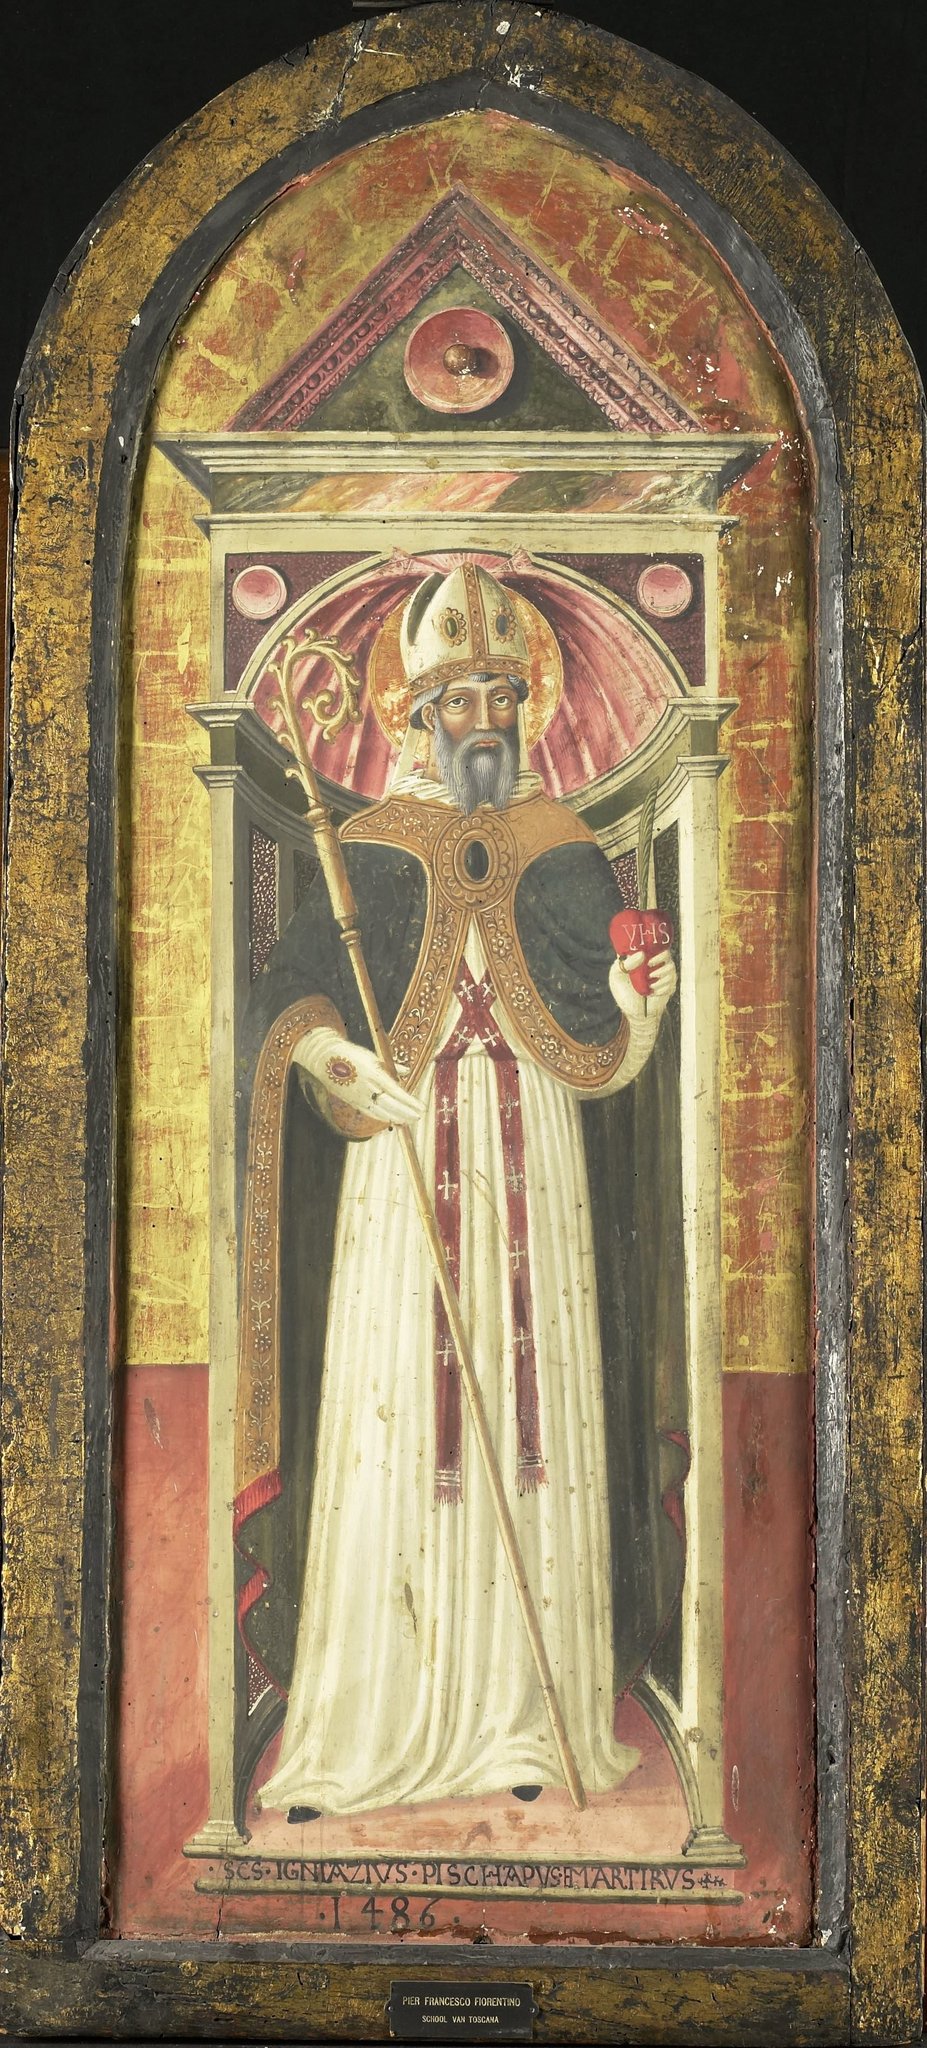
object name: fragment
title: Saint Ignatius of Antioch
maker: Anonymous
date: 1460-1499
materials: oil, panel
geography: tuscany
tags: the bishop of antioch, ignatius (theophoros); possible attributes: heart with ihs monogram, (two) lion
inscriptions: : ‘Scs Igniazius. Pischapus. Martirus. 1486’, inscription: ‘Scs Igniazius. Pischapus. Martirus. 1486’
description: De heilige Ignatius van Antiochie. De heilige bisschop staande, ten voeten uit, bisschopsstaf in de rechterhand, een hart met palmtak in de linkerhand. Behoorde samen met SK-A-3397 tot een groter altaarstuk of ensemble.